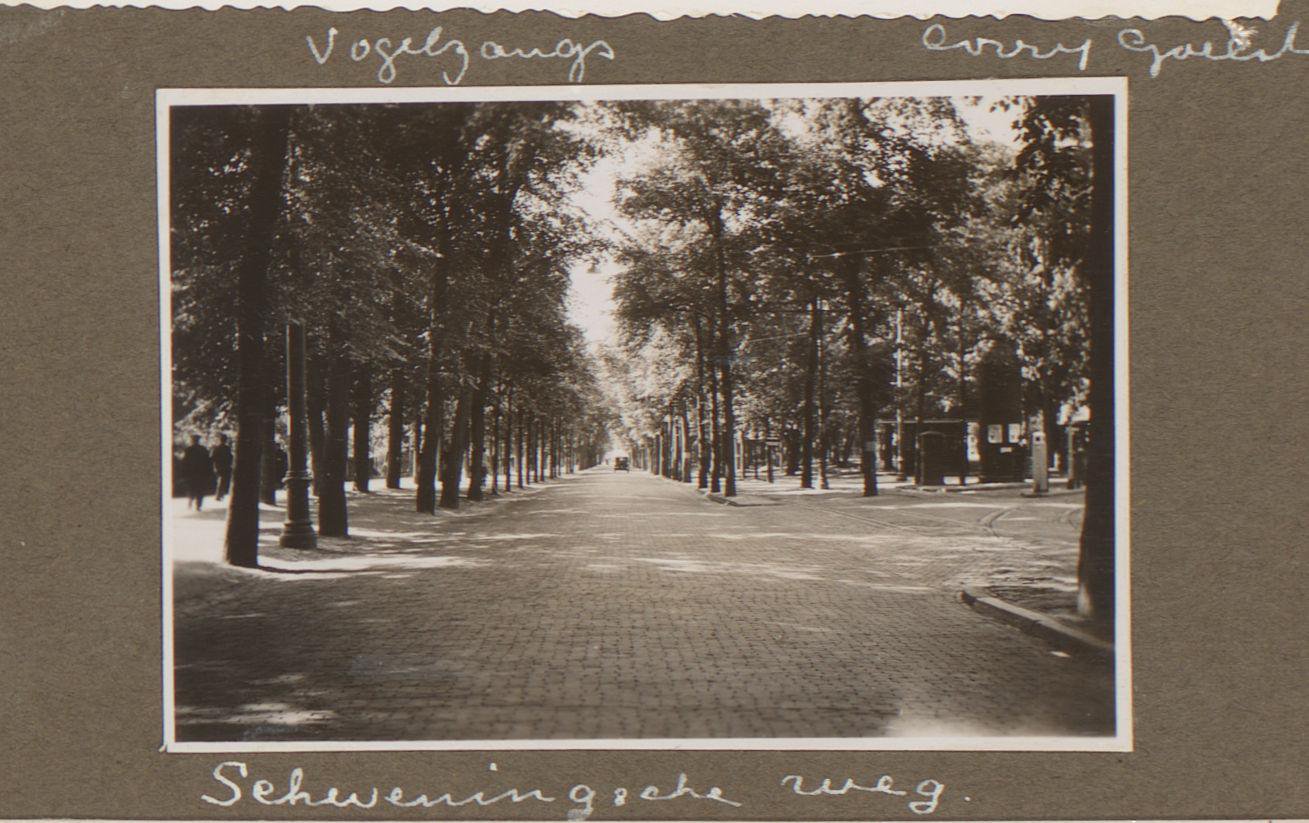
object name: album leaf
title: Gezicht op de Scheveningseweg in Den Haag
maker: Anonymous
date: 1932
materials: paper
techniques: gelatin silver print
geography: the hague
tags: public road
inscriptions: inscription: ‘Scheveningsche weg’